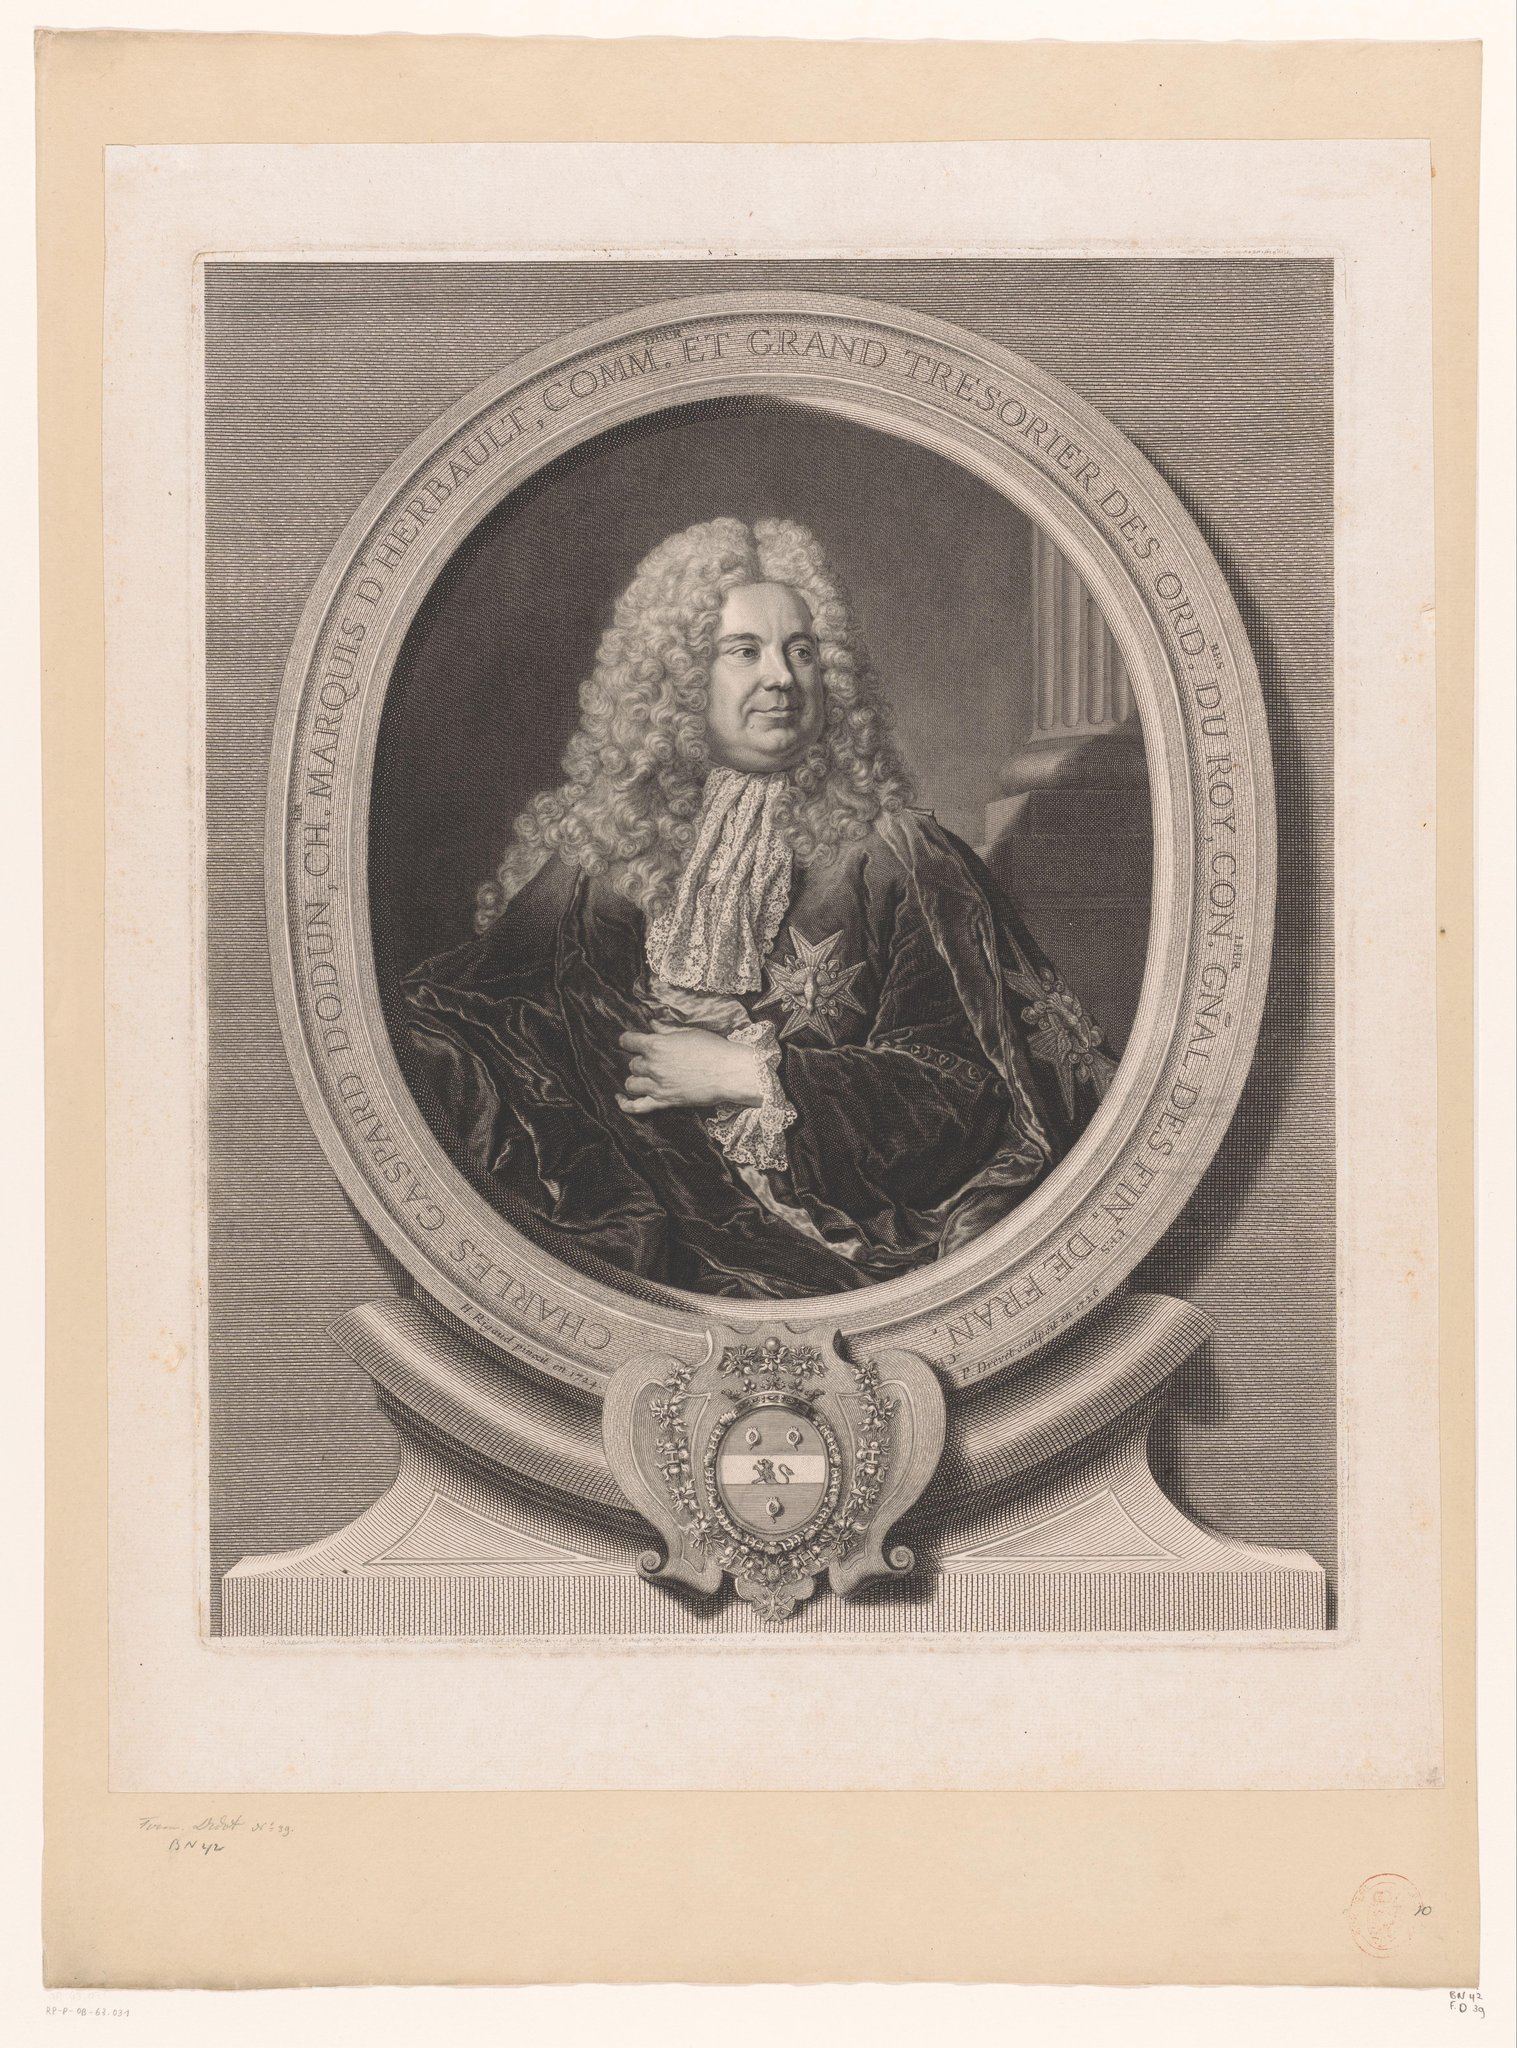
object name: print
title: Portret van Charles Gaspard Dodun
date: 1726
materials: paper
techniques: engraving, etching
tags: paris, official; civil servant; functionary (in general), historical persons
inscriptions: collector's mark: Lugt 240